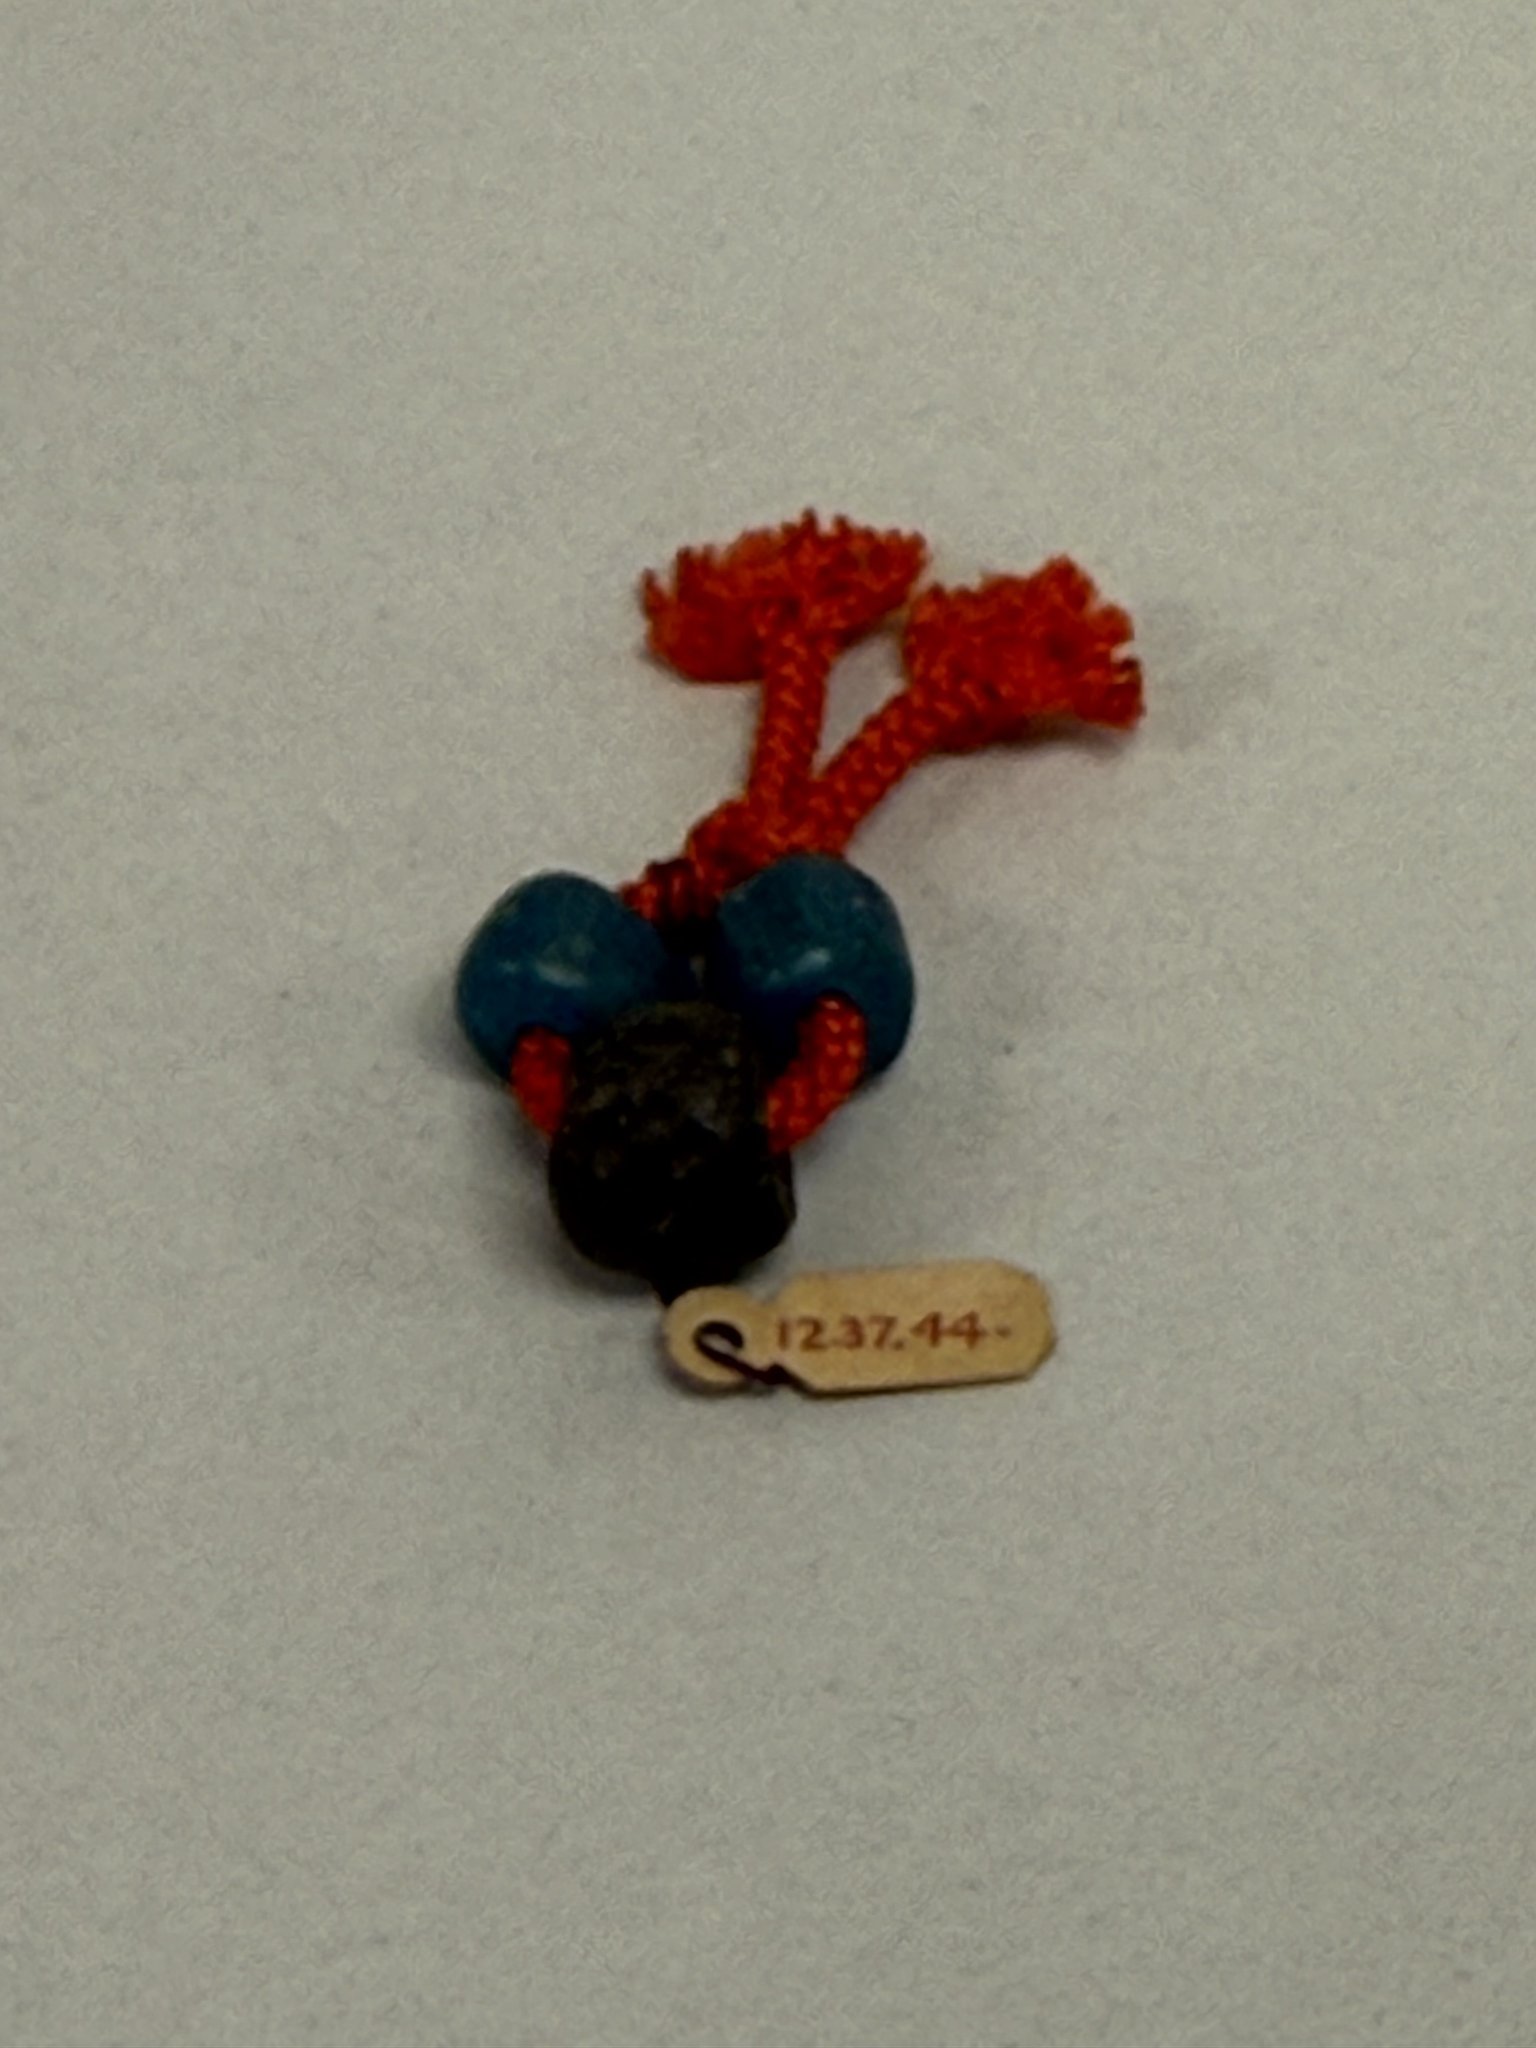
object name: bead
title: Beads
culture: japanese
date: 601-700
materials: glass, lacquer